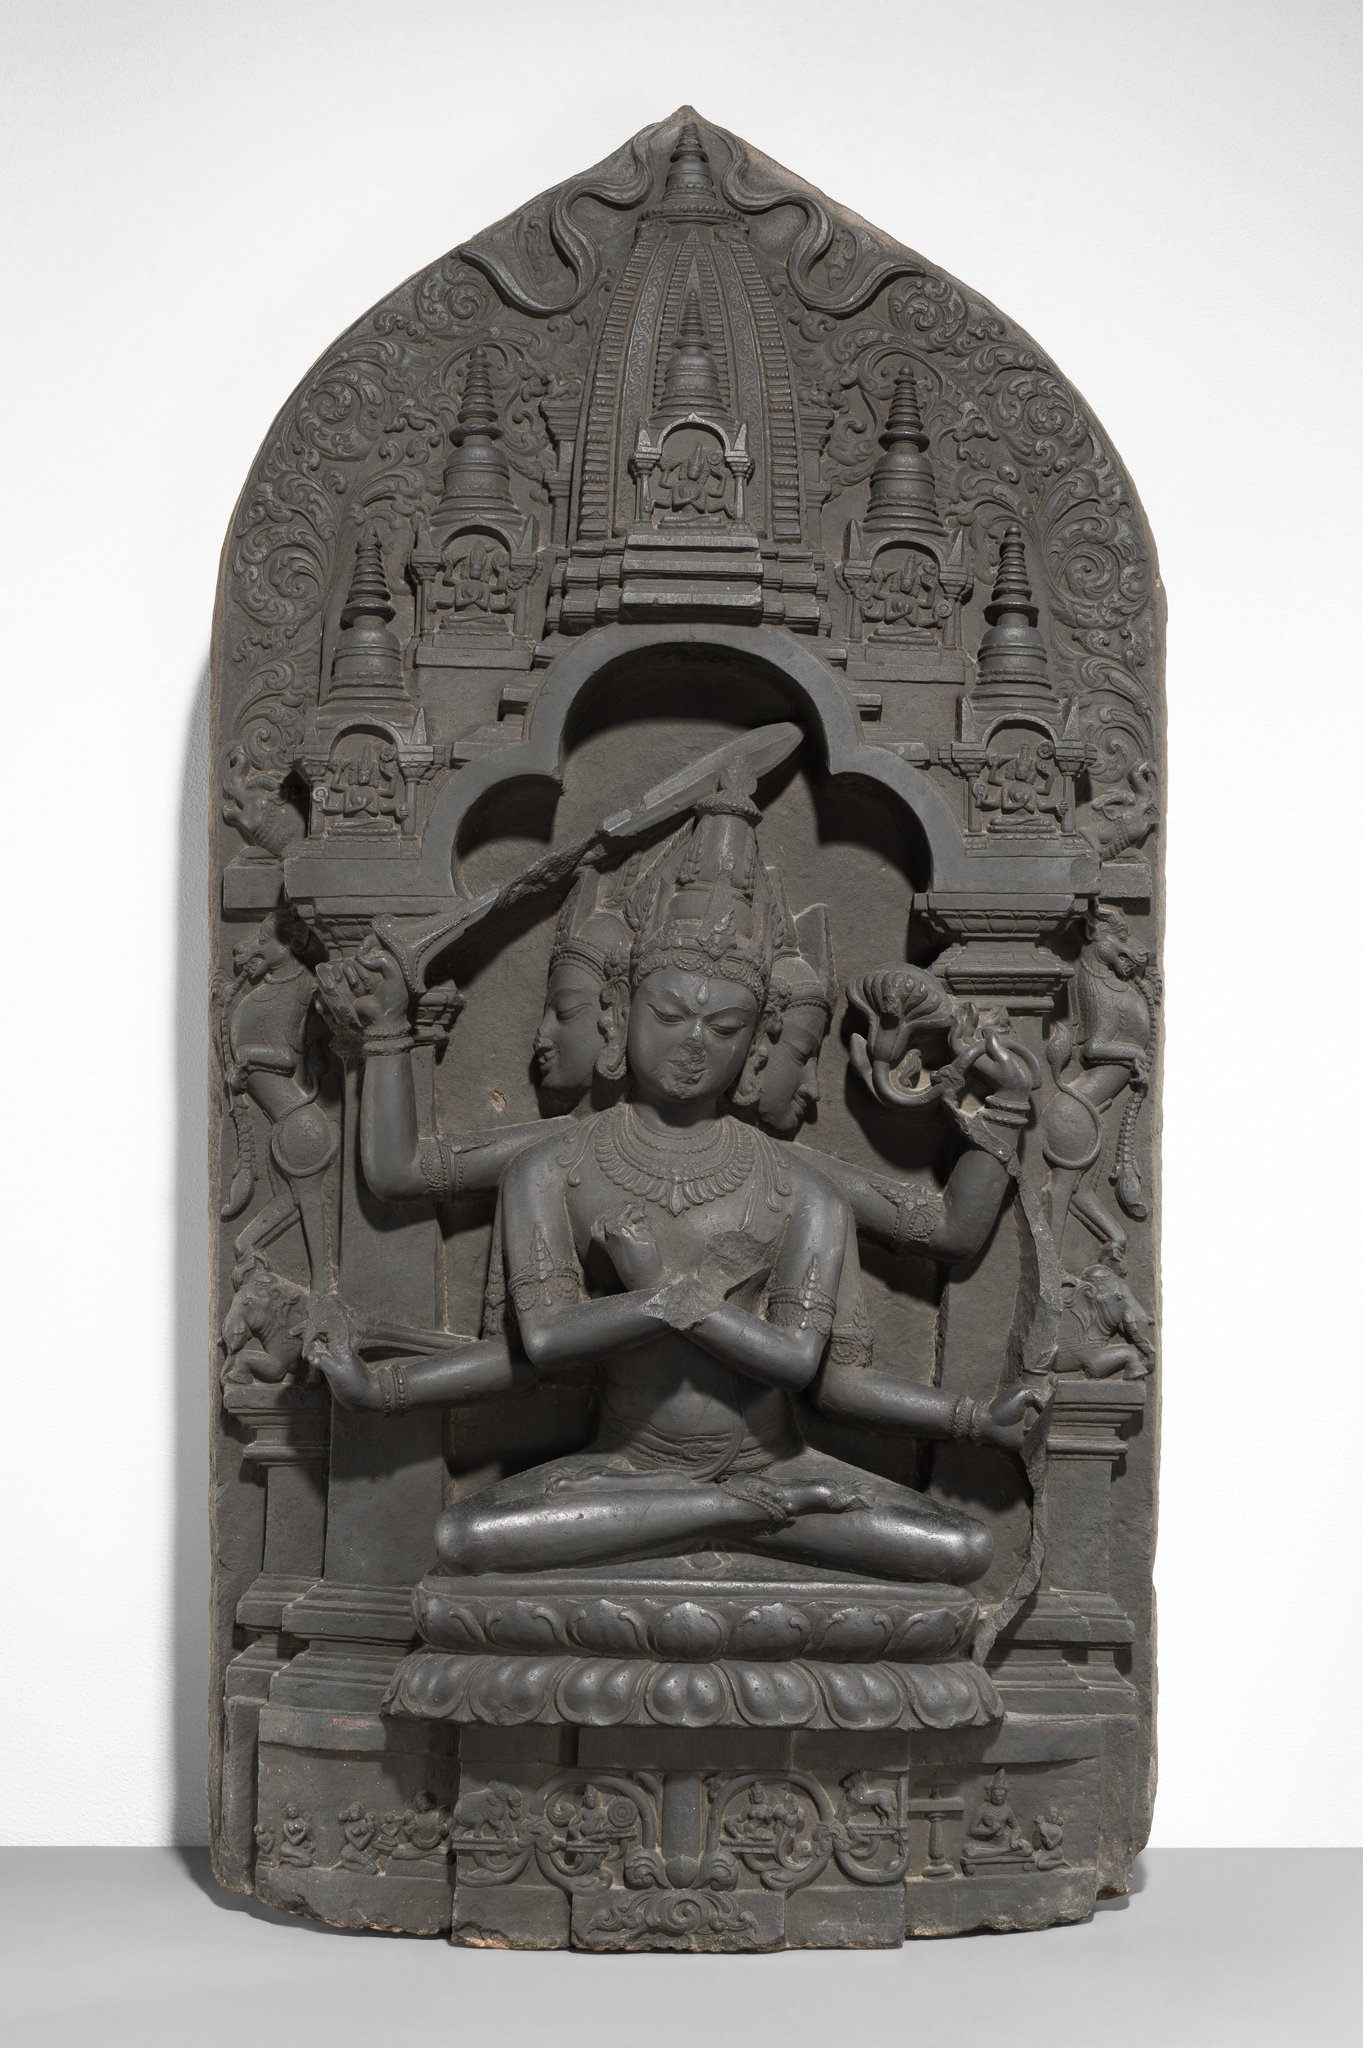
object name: relief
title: Manjuvajra Mandala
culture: bangladeshi or indian or bengali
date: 1001-1100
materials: stone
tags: swords,buddhism,bodhisattvas,manjushri,stupas